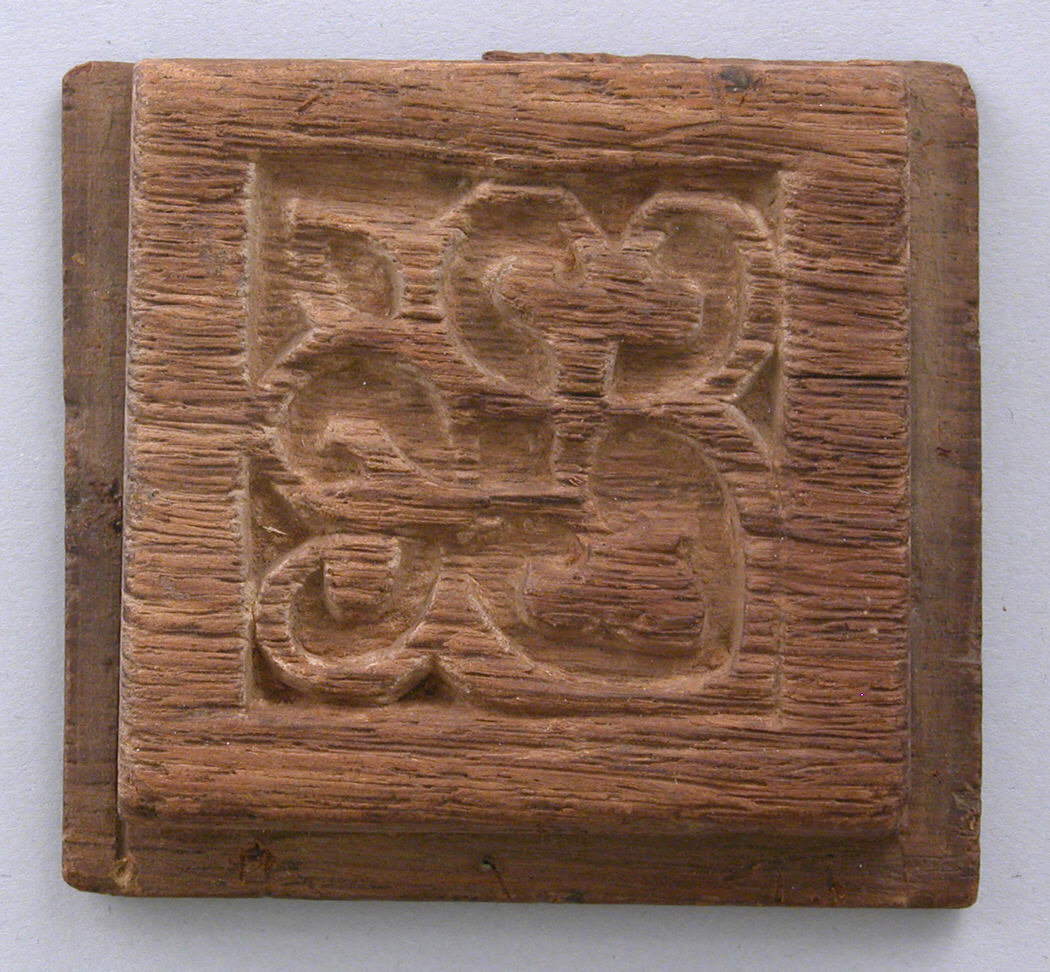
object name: panel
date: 1301-1500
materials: wood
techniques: carving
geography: egypt